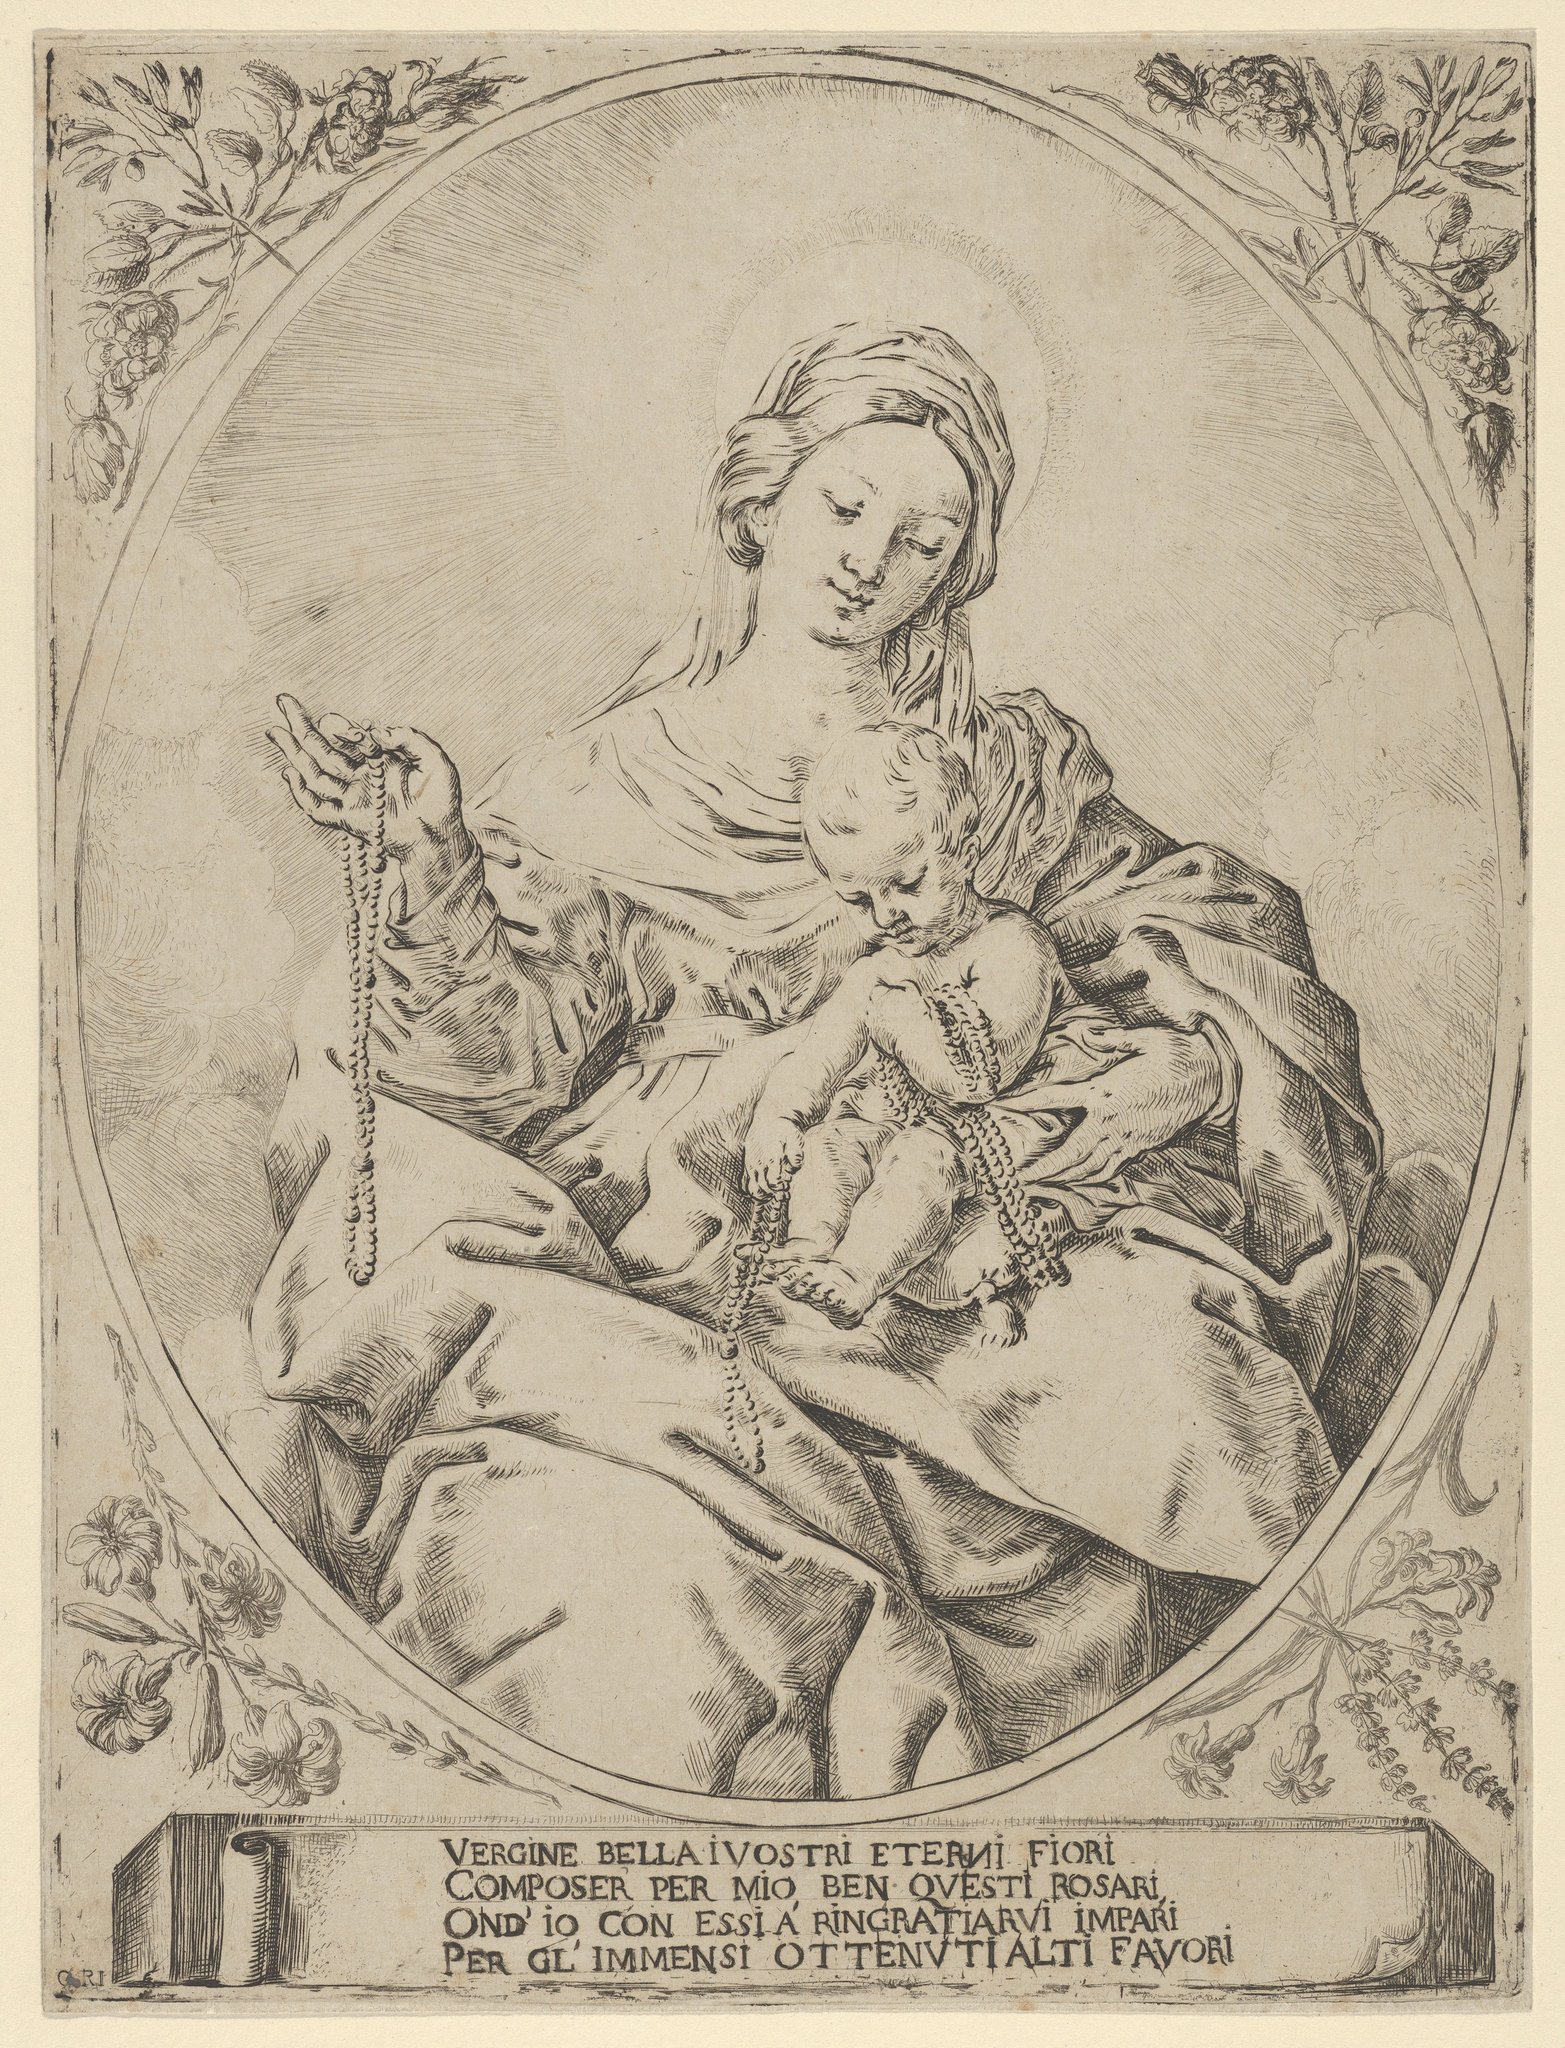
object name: print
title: The Virgin seated holding a rosary in her right hand, the infant Christ on her lap holding several rosaries, in an oval frame with flowers surrounding it and a tablet with inscription at the base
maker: Anonymous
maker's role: artist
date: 1601-1700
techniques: etching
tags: flowers,christ,madonna and child,rosaries